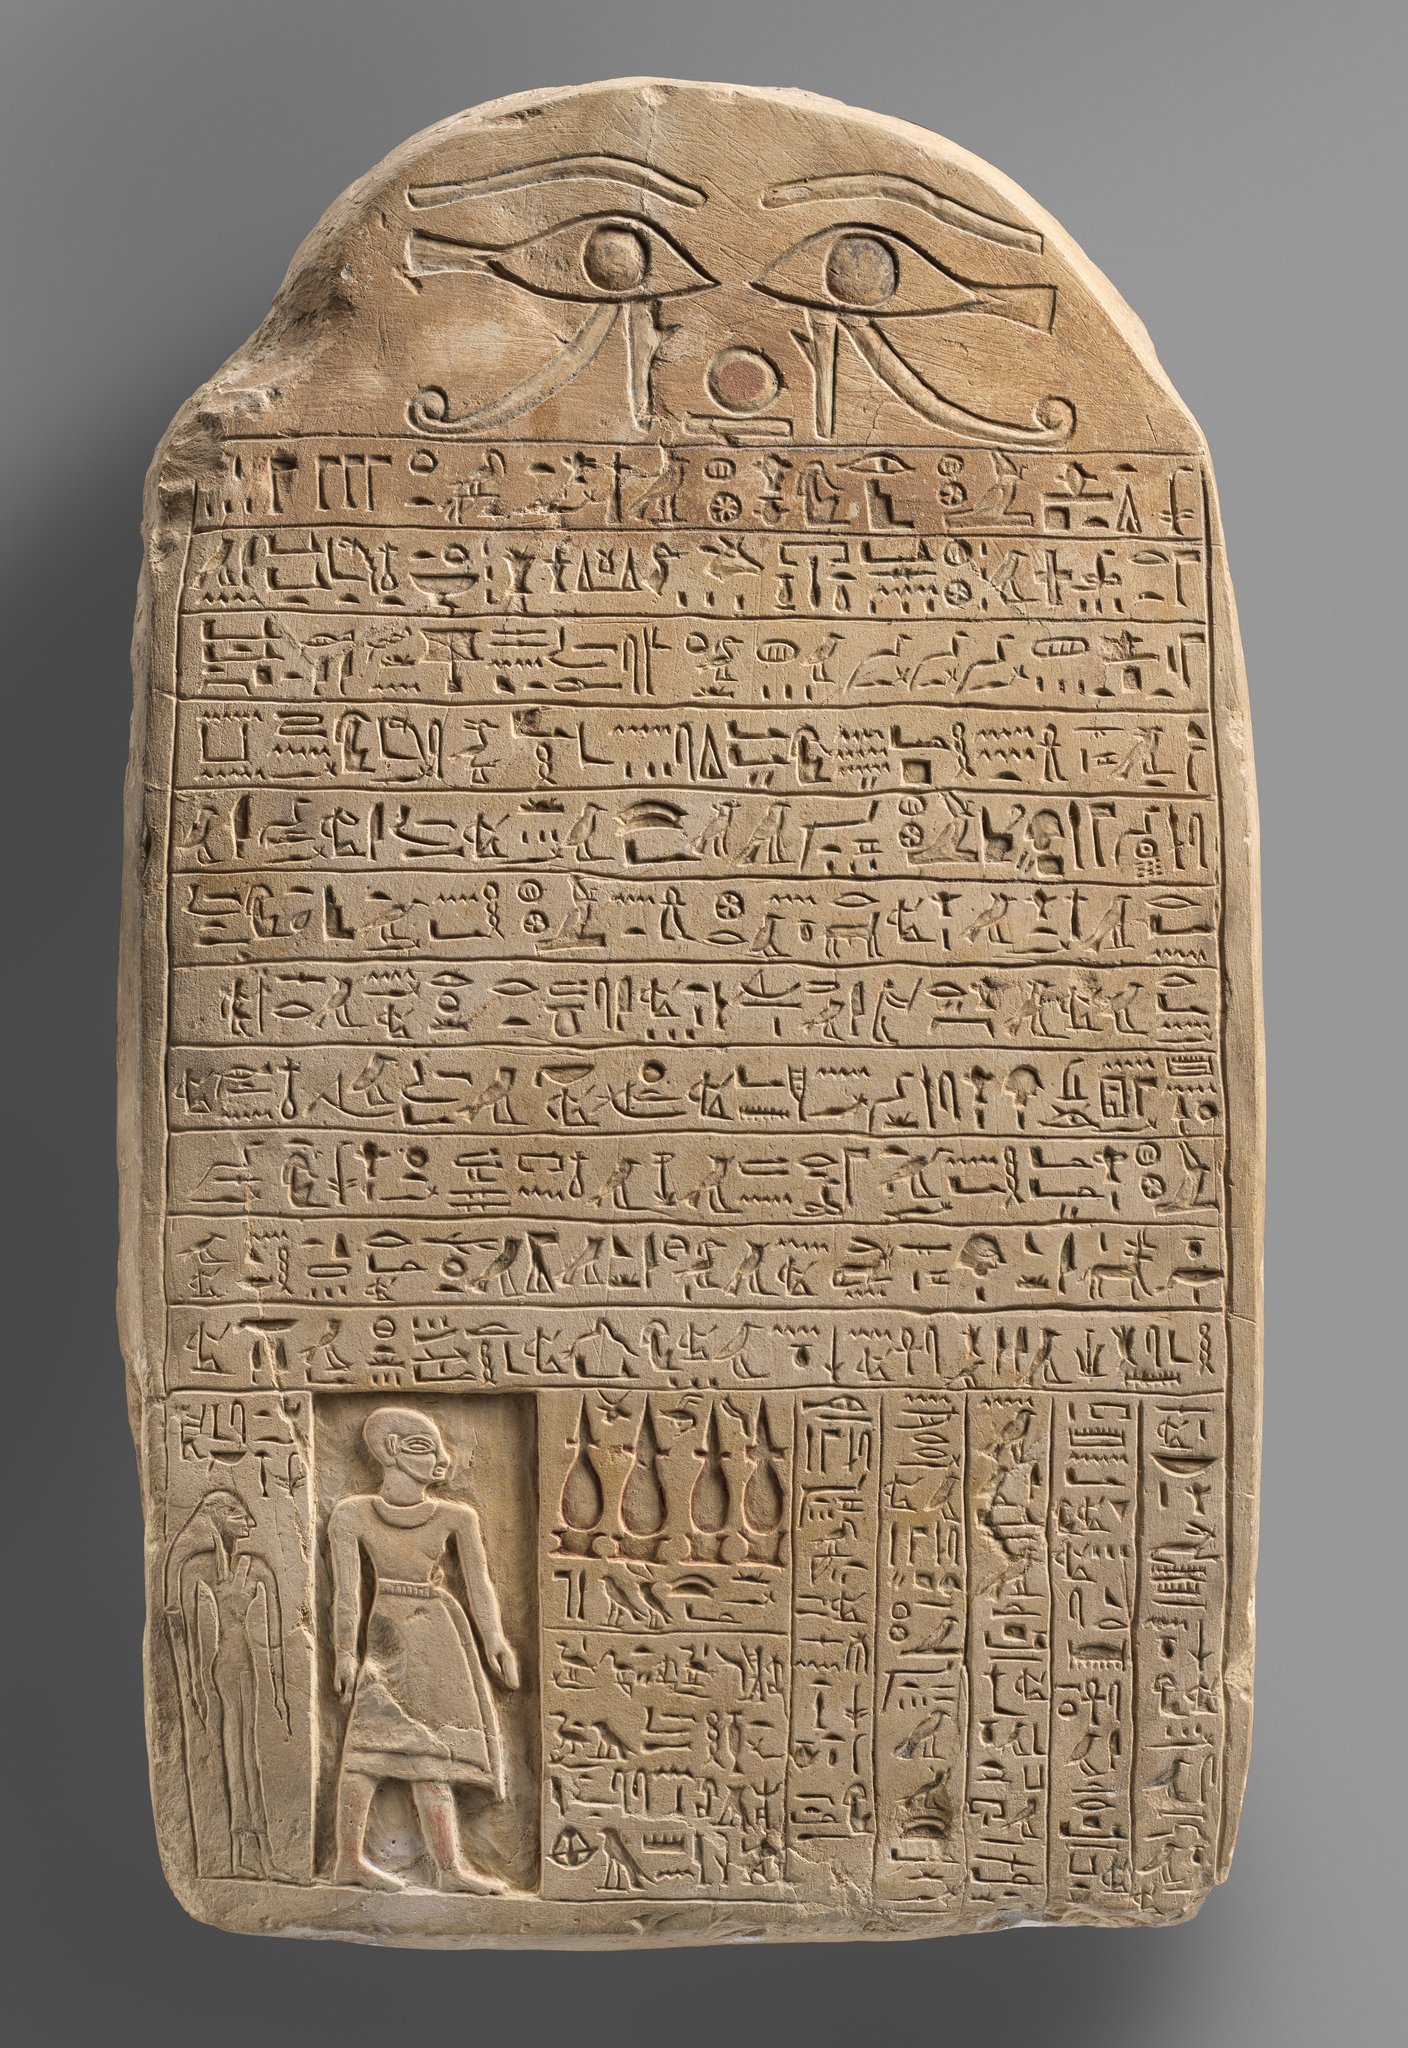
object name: stela, horemkhauef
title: Stela of Horemkhauef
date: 1802-1640 BCE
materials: limestone, paint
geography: egypt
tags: eyes